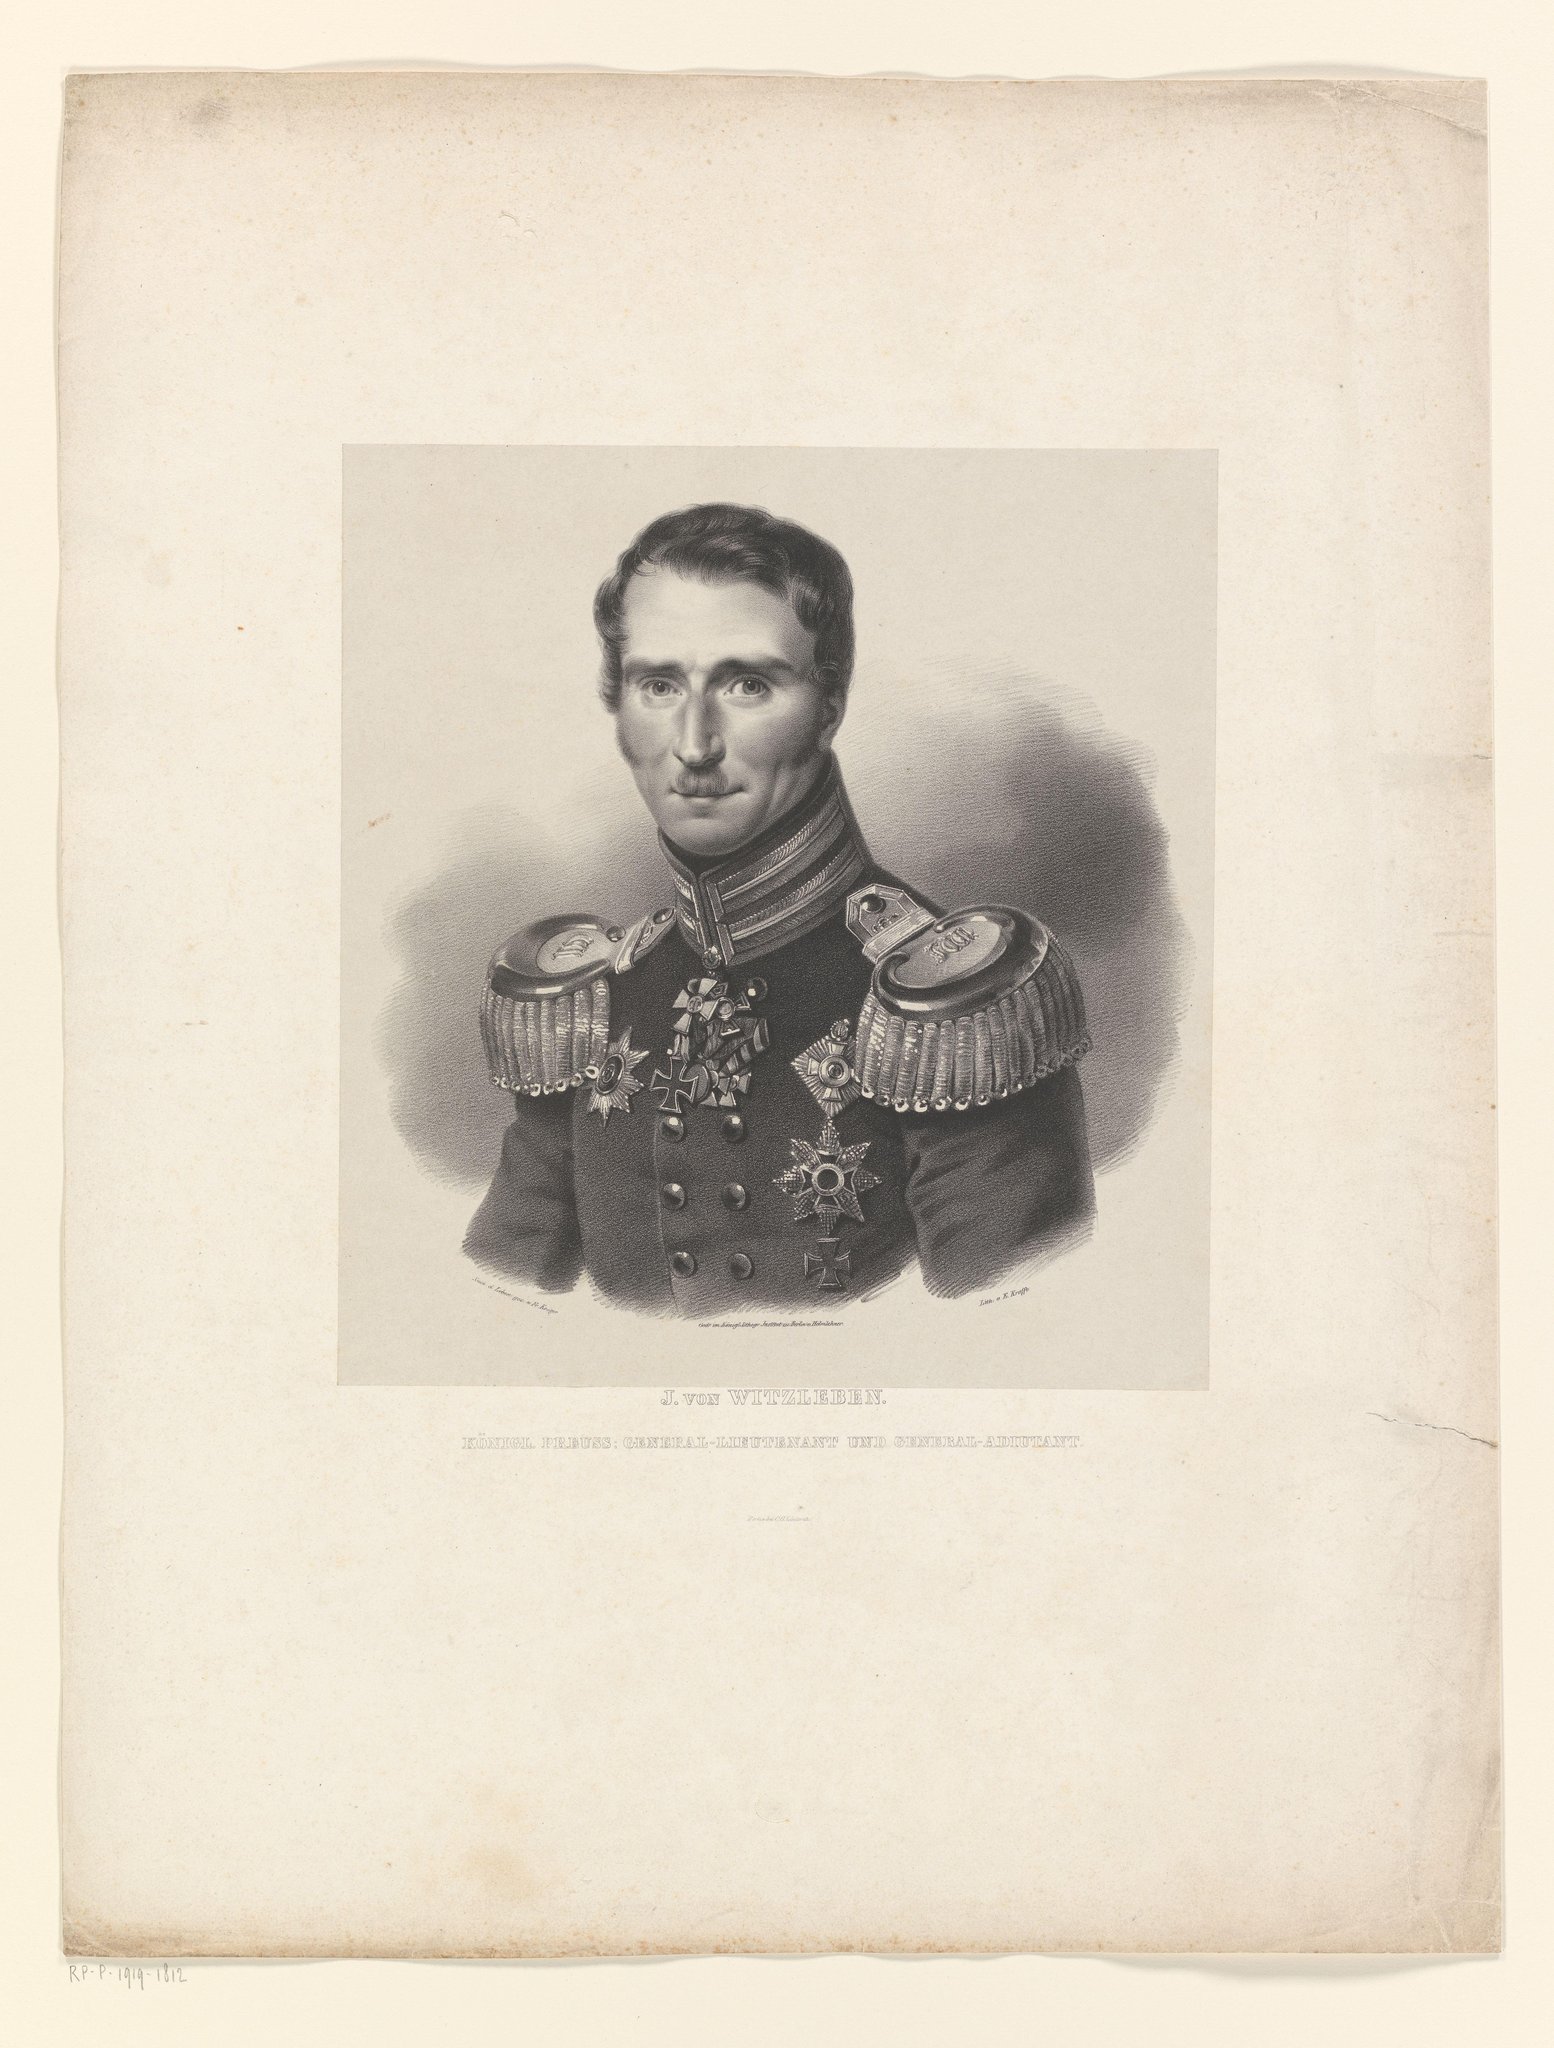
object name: print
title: J. von Witzleben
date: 1821-1837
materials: paper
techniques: lithograph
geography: berlin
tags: berlin, politician, moustache, commander-in-chief, general, marshal, historical persons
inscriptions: check stamp: Lugt 4519, collector's mark: Lugt 2228